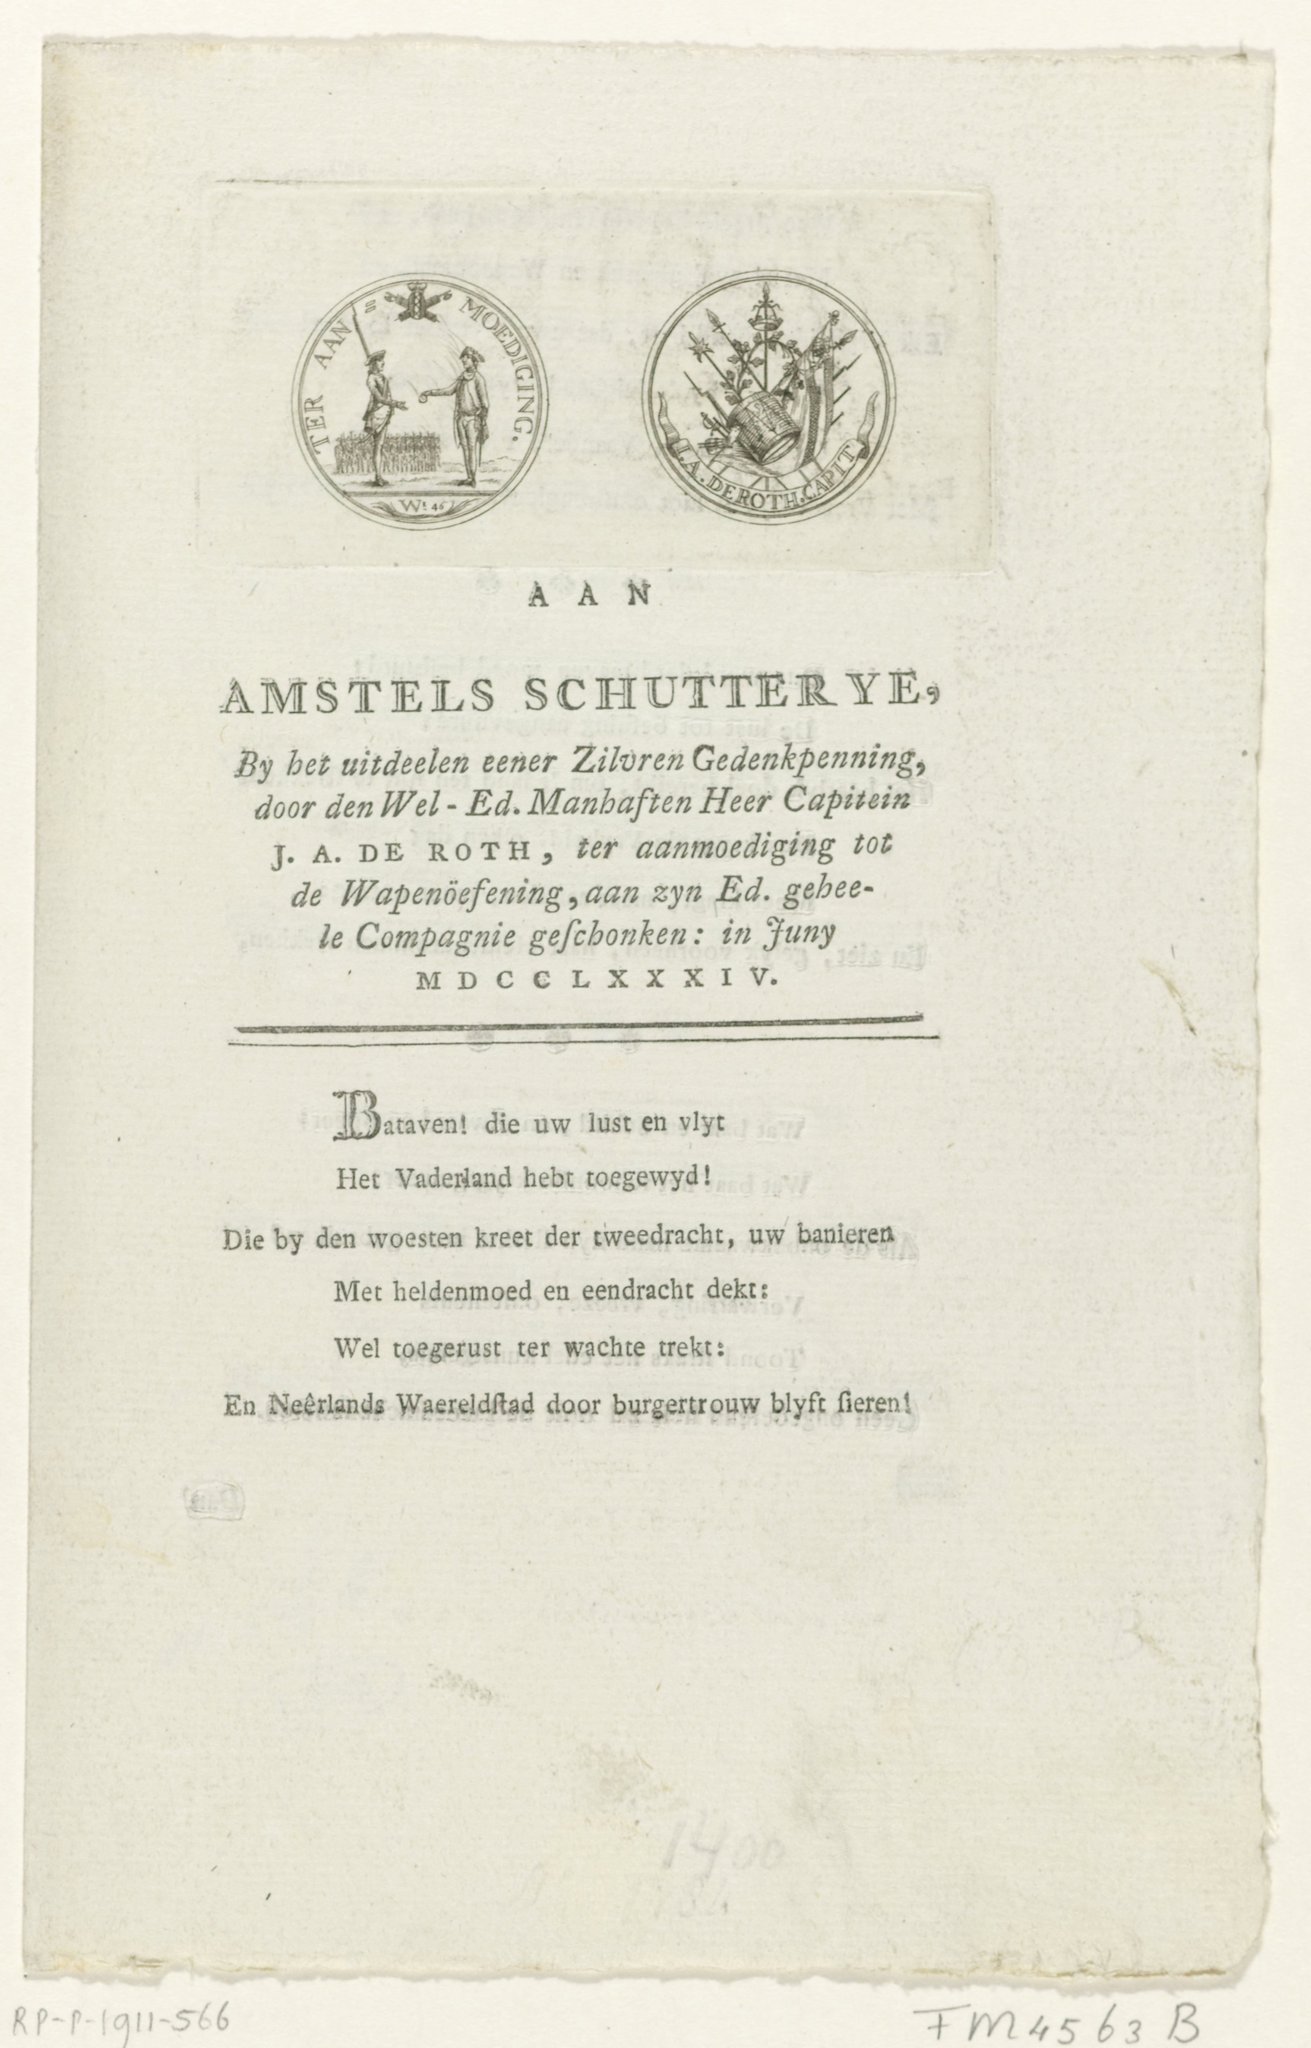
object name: print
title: Blad over de penning uitgereikt door J.A. Roth aan de Amsterdamse schutterij, 1784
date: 1784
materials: paper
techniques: etching, letterpress printing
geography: amsterdam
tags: medal (considered as a piece of sculpture, regardless of its specific function), amsterdam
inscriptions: collector's mark: Lugt 2228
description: Voor een exemplaar van deze zilveren penning in de collectie van het Rijksmuseum zie objectnummer NG-VG-1-2879. Adolf Octave van Kerkwijk , 'De penningen door Johan George Holtzheij tusschen 1777 en 1784 vervaardigd', Jaarboek voor Munt- en Penningkunde 6 (1919), p. 98-99, nr. 52. beschrijft de vondst van het winkelboek van de zegelsnijder Holtzheij, (destijds) aanwezig in de Rijksmunt te Utrecht. Deze in Amsterdam opererende Holtheij blijkt de vervaardiger te zijn geweest van de schutterspenning van Jacob Anthonij de Roth. De twee penningen in de collectie maken onderdeel uit van de in 1783 en 1784 geslagen series van totaal 100 penningen. Dit voegt meteen ook informatie toe aan het drukwerkje dat t.g.v. de aanbieding van deze schutterspenning in de maand juni in 1784 bestaat (o.a. opgenomen in Jan Wagenaars 'Amsterdam in zyne opkomst, aanweas, geschiedenissen, voorregten (etc)') met de titel "Aan Amstels Schutterye, bij het uitdeelen eender Zilveren Gedenkpenning, door den Wel- Ed.Manhaften Heer Capitein J.A. de Roth, (etc.)", bij u opgenomen met catalogusreferentie FMH 4563-8, en met objectnummer RP-P-1911-566. [Mededeling Herman de Wit, Maarssen, 2012-08-05]